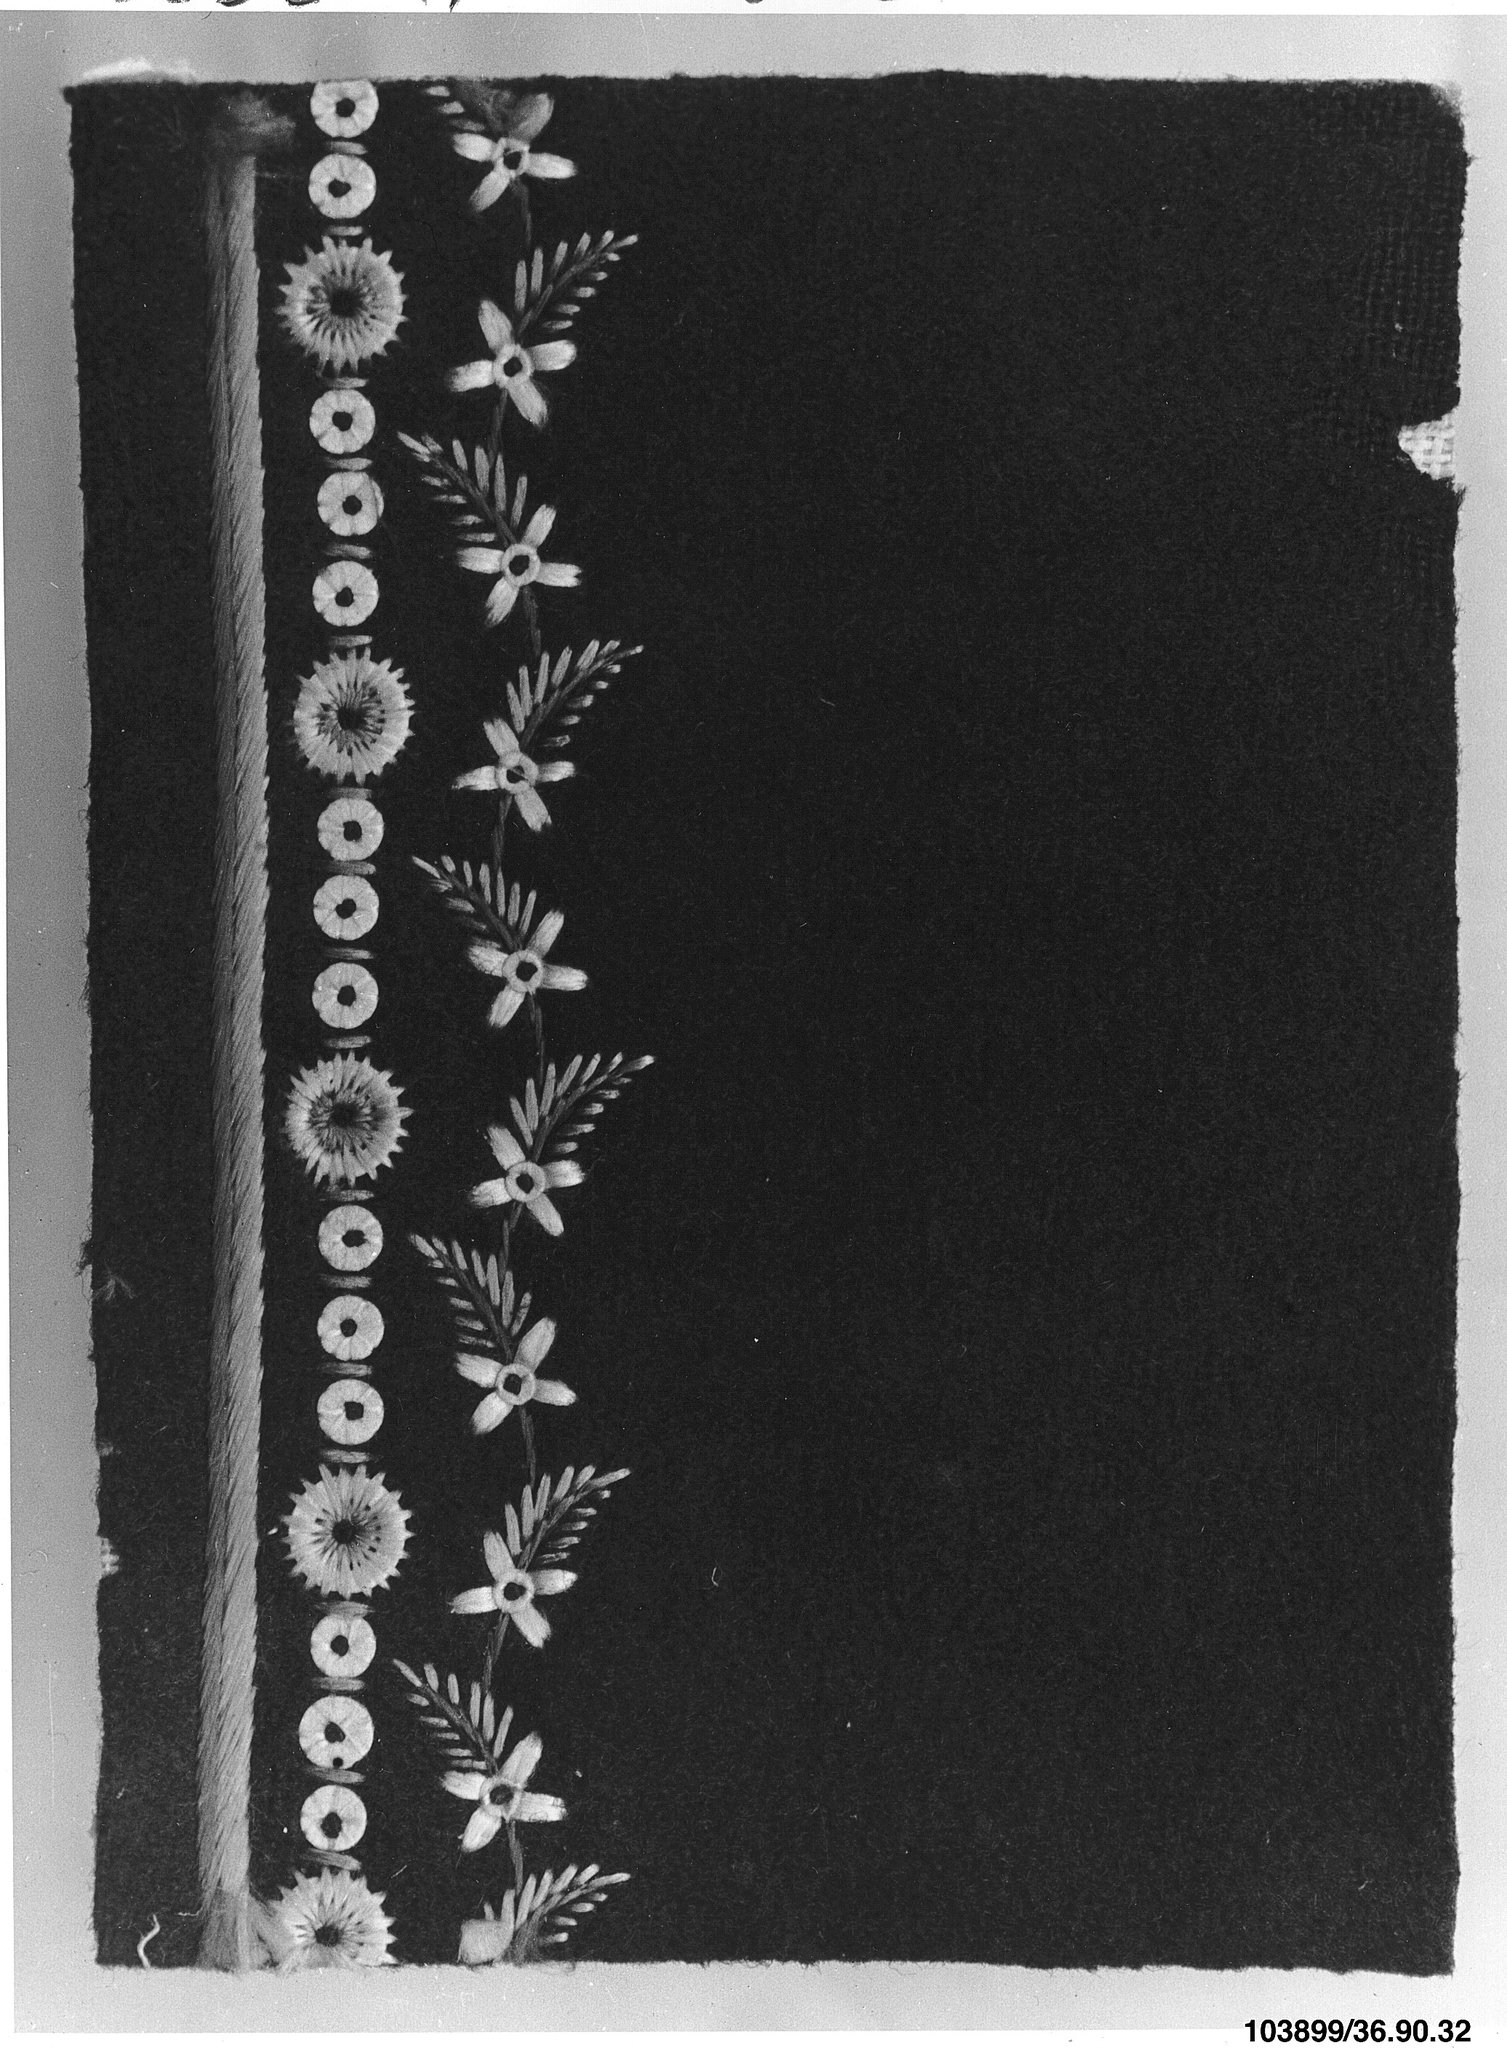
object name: sample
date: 1801-1833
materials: silk, wool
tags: flowers